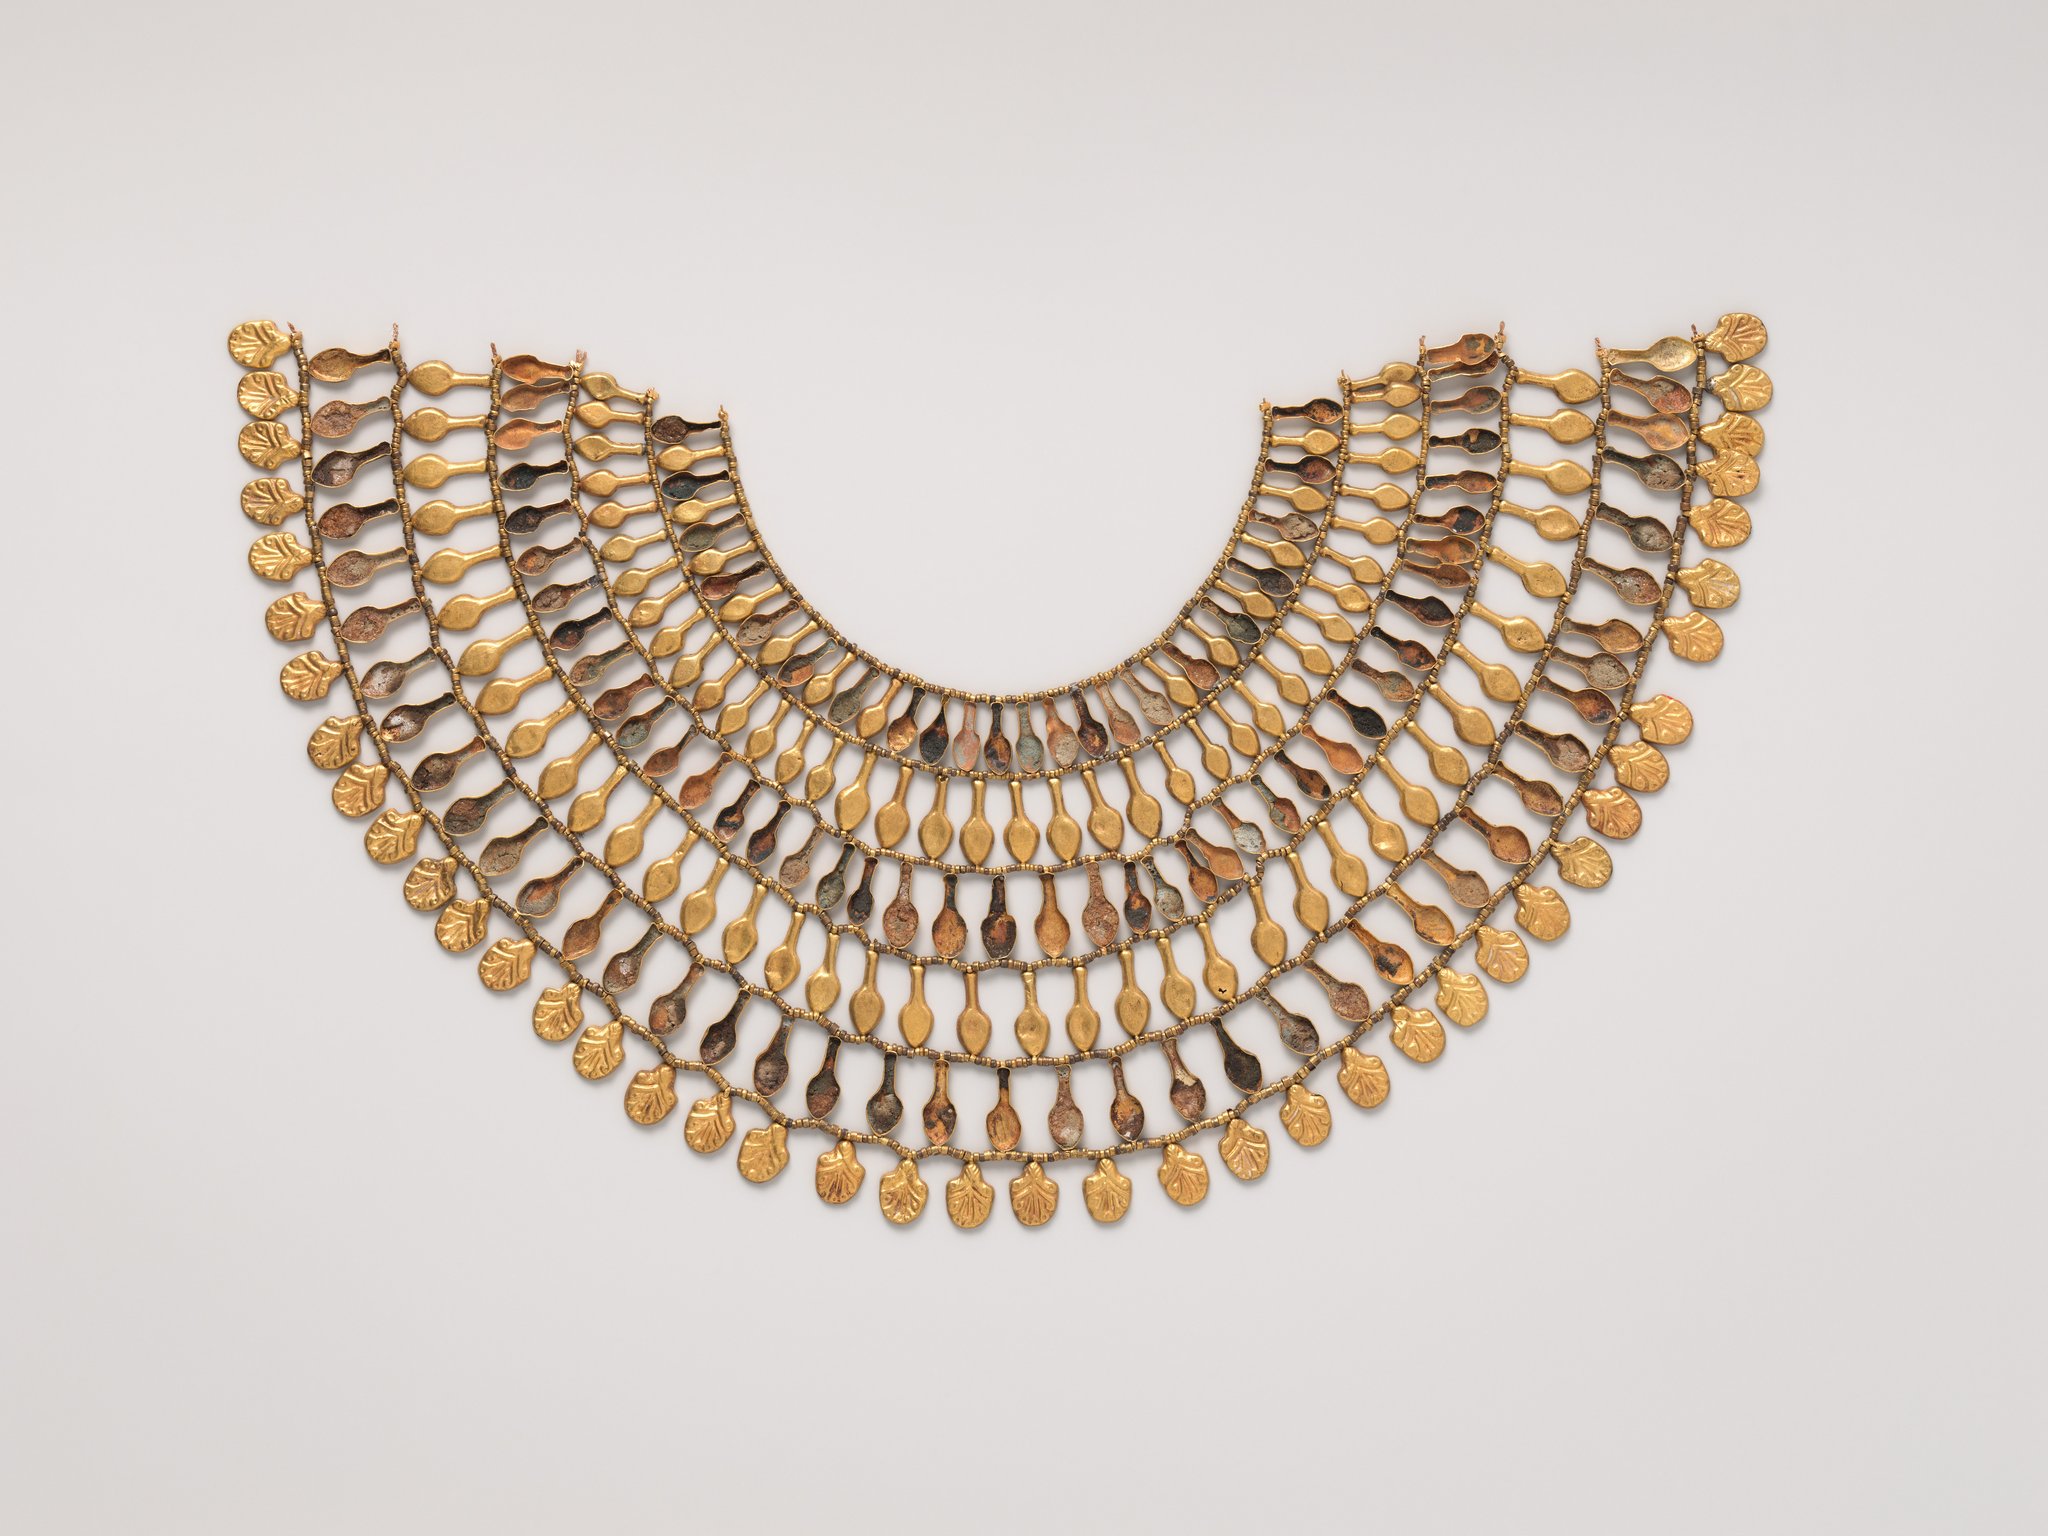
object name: broad collar, nefer amulet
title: Broad collar of Nefer Amulets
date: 1504-1450 BCE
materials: glass, gold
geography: egypt